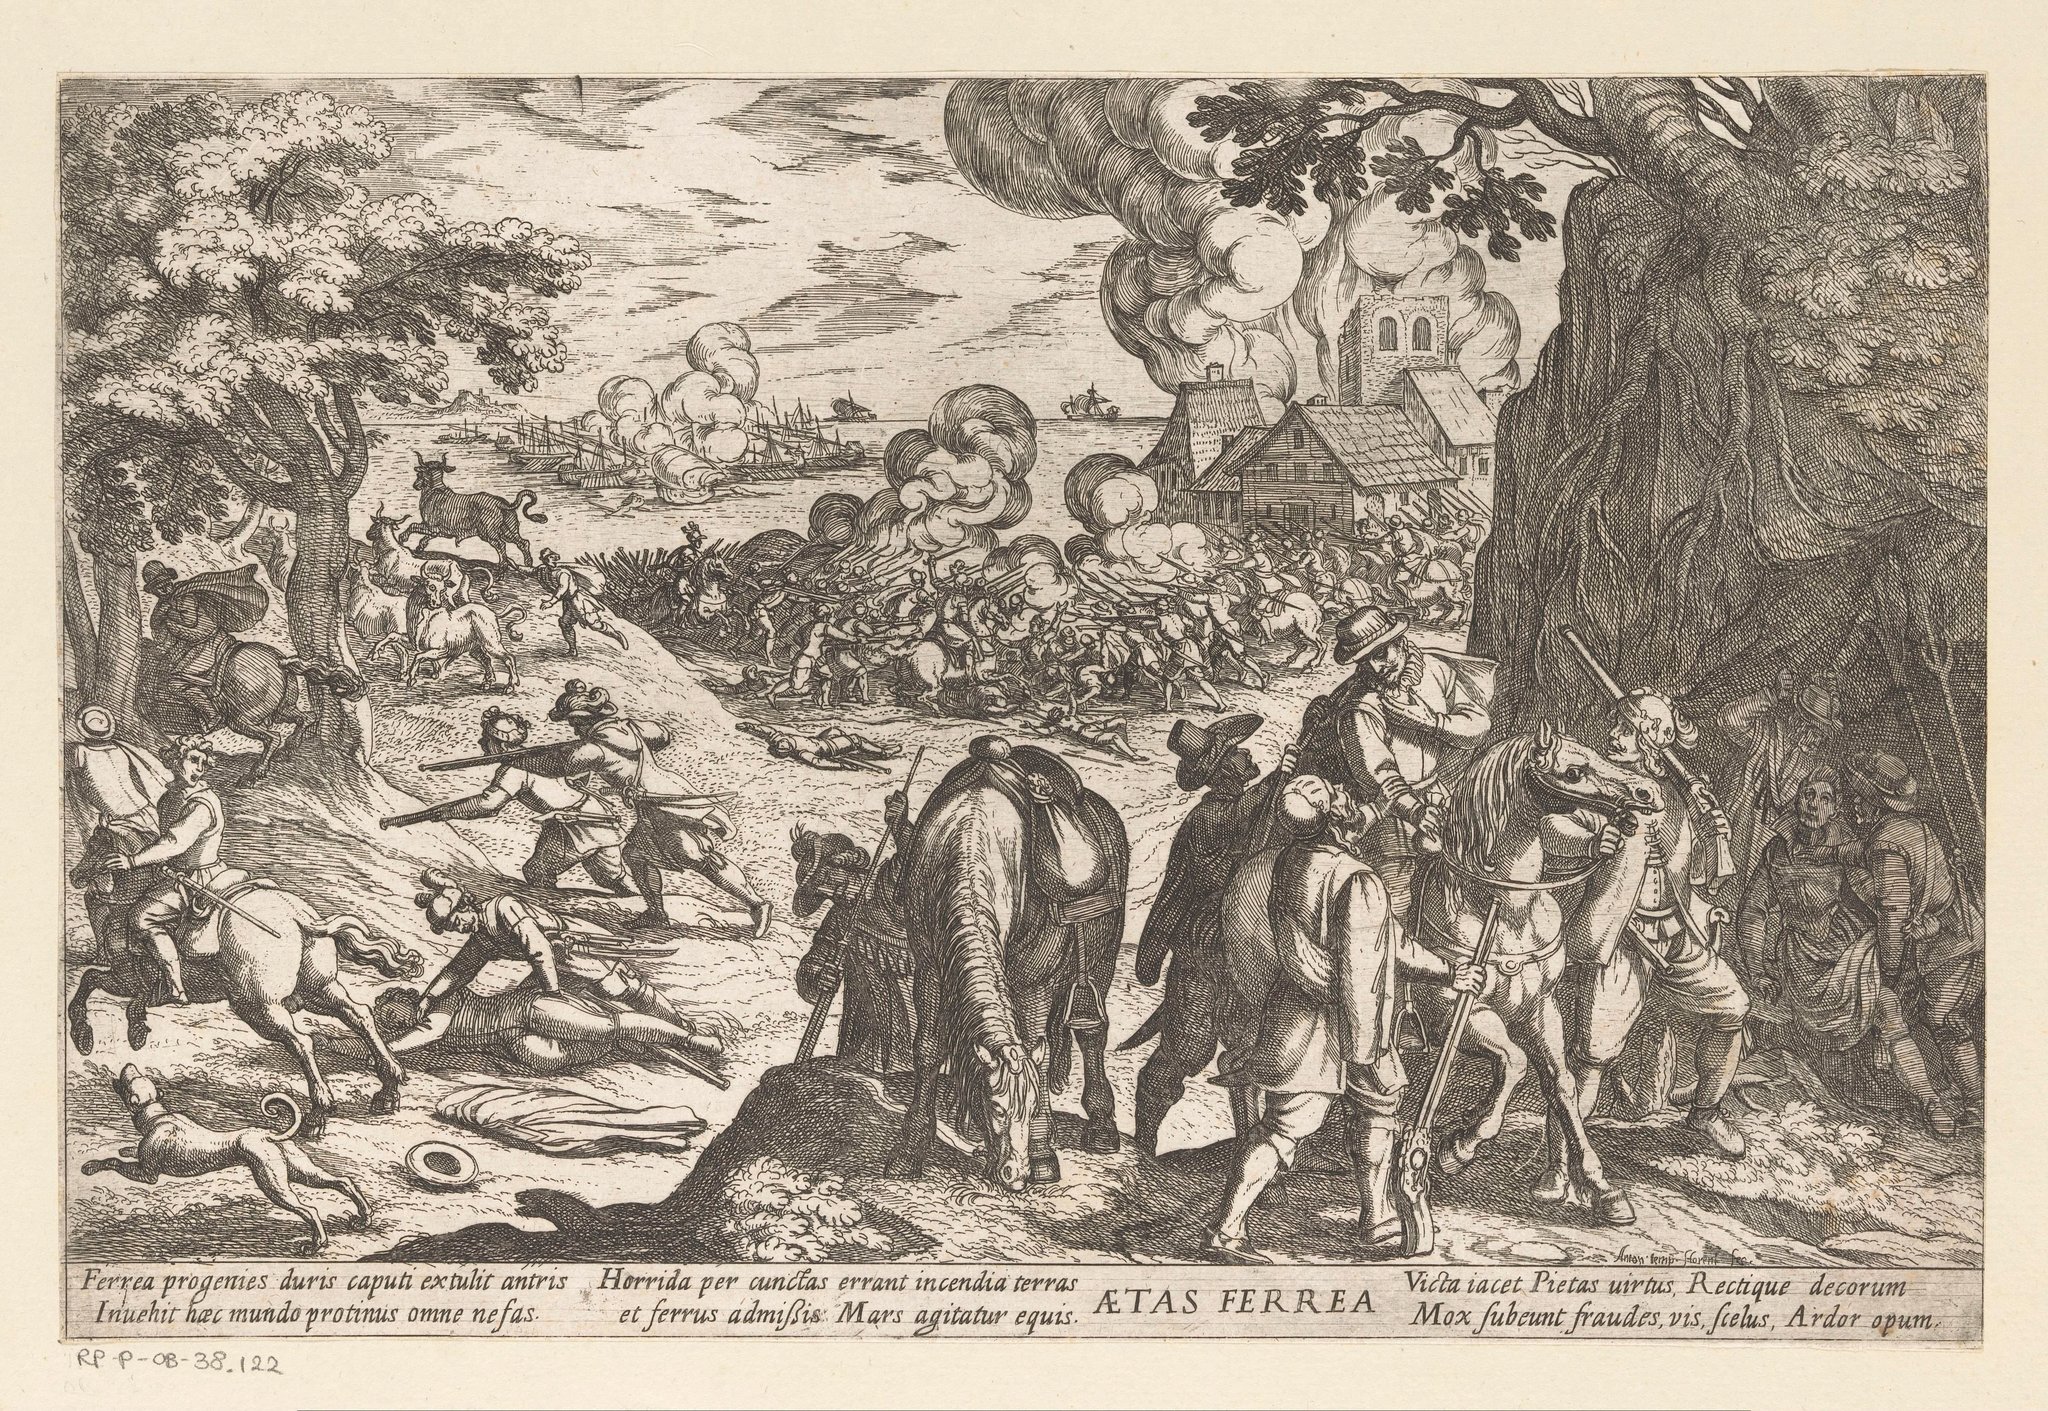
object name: print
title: Aetas ferrea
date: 1599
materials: paper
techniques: etching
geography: rome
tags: the iron age, 'aetas ferrea'; characterized by mars, war and rapine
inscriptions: collector's mark: Lugt 240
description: Het ijzeren tijdperk: soldaten passeren een dorp en plunderen, vermoorden en verkrachten. Op de achtergrond staat een stad in brand. Onderschrift en titel in het Latijn in ondermarge.